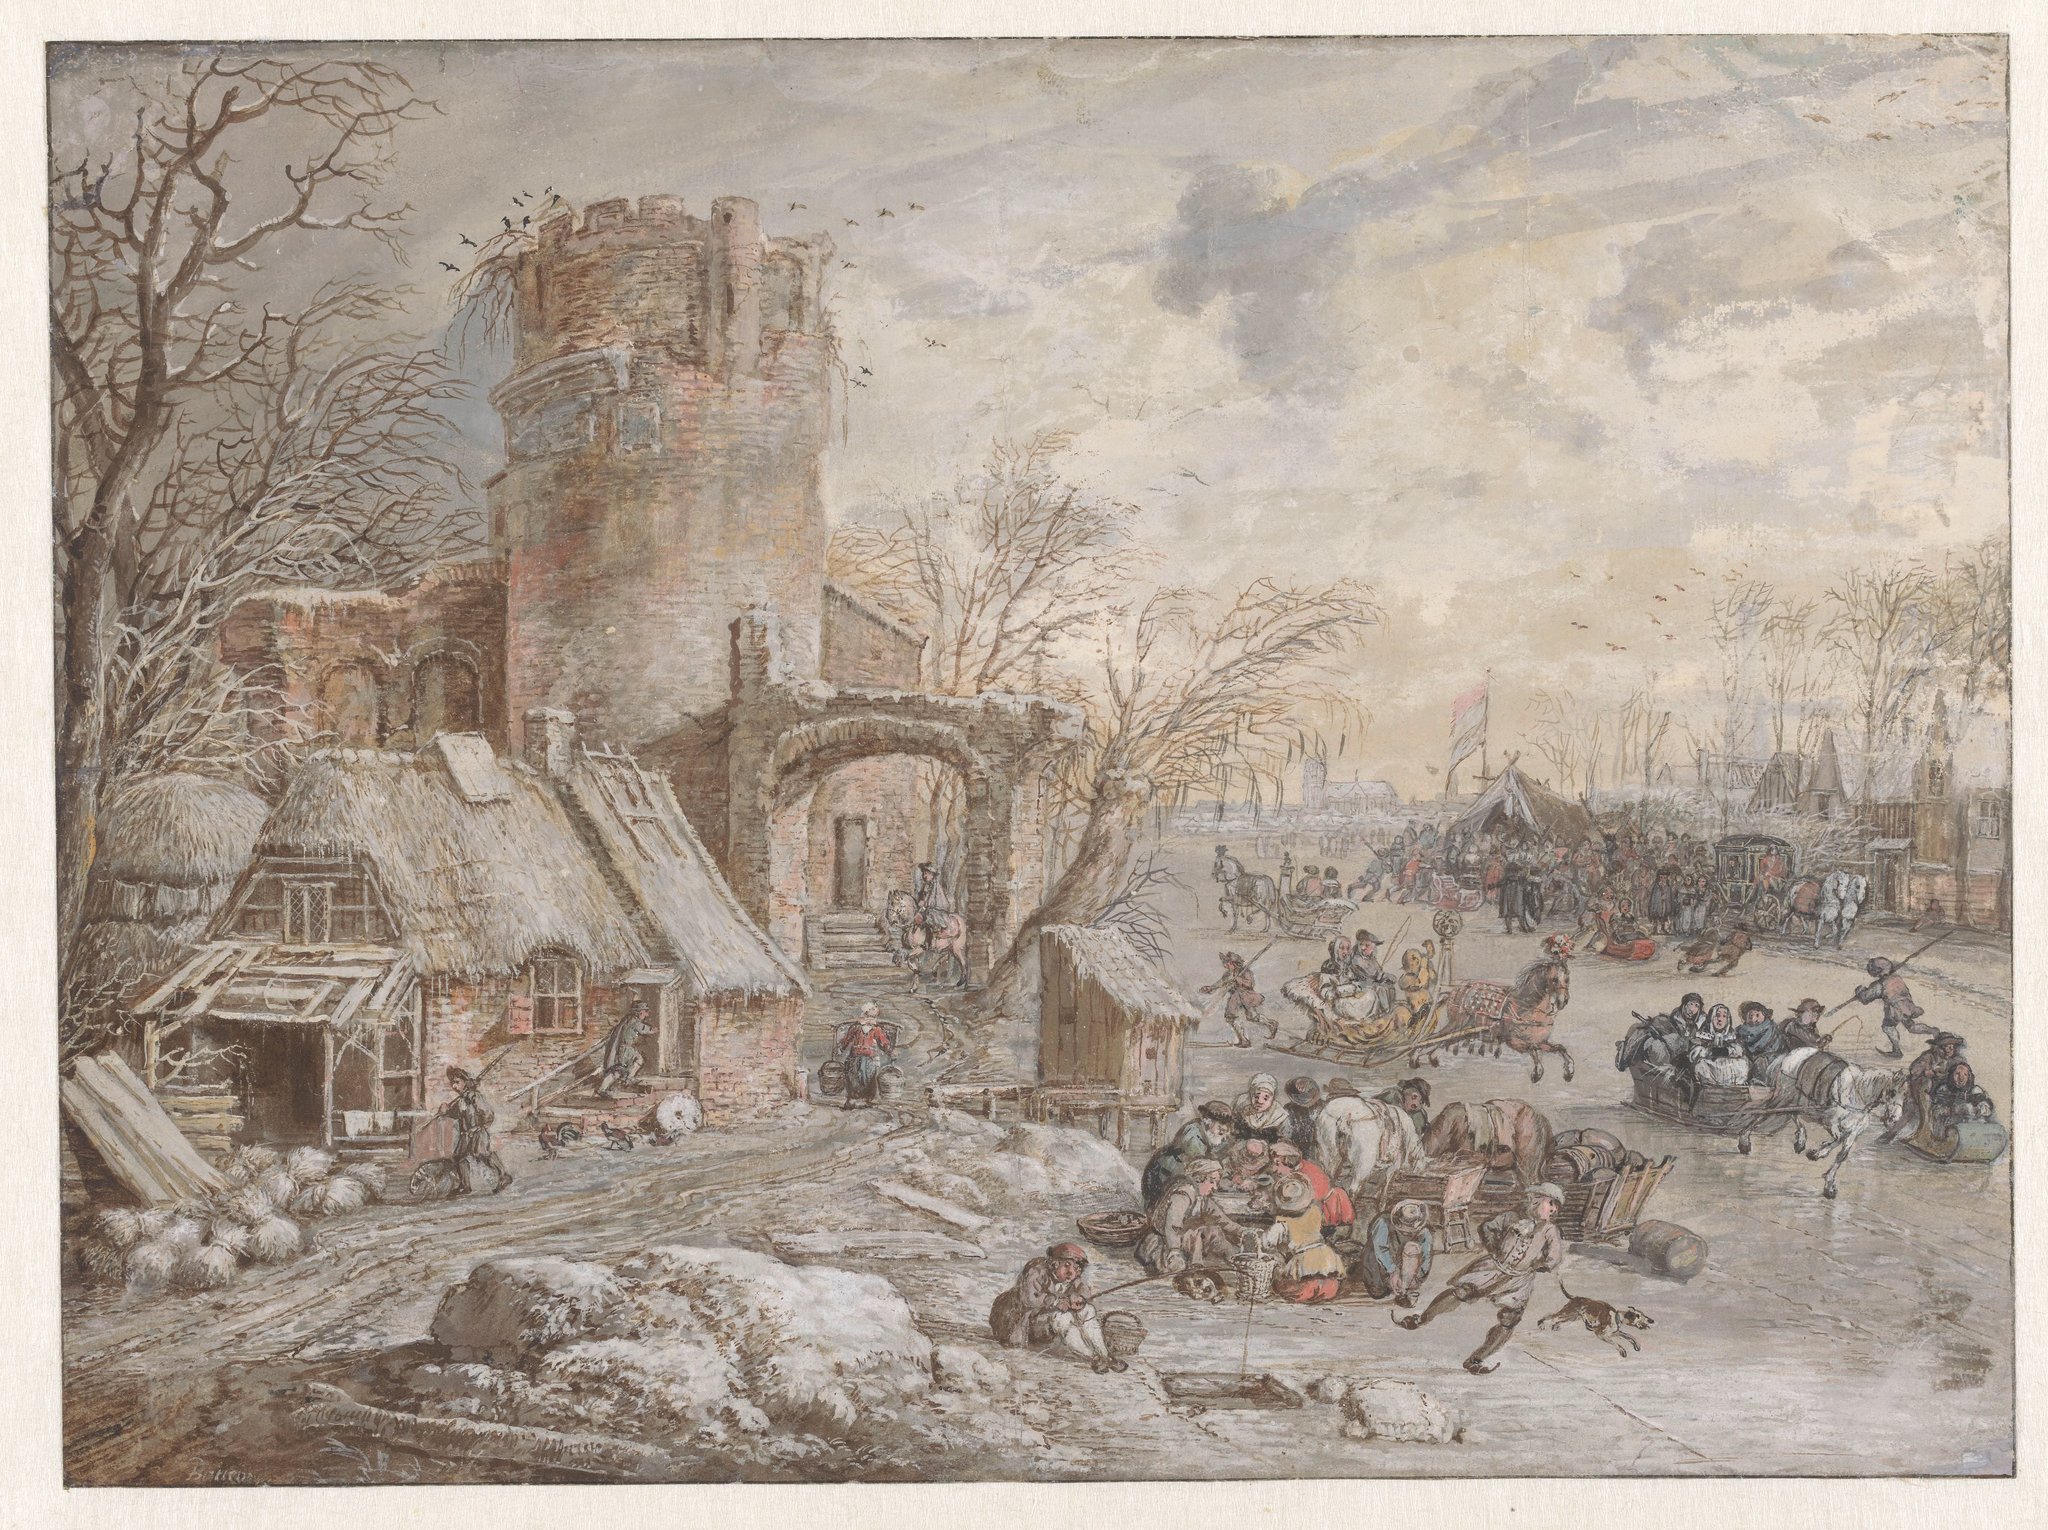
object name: drawing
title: Winterlandschap met ijsvermaak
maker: gerrit battem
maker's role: draughtsman, painter, print maker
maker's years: 1636-1684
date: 1646-1684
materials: paint, gouache, paper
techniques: brush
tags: winter sports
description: Winterscène met links een huis en een vervallen toren en rechts ijsvermaak op een bevroren water: schaatsers, enkele arrensledes, een koets bij een tent, een hengelaar en in de verte een stad.